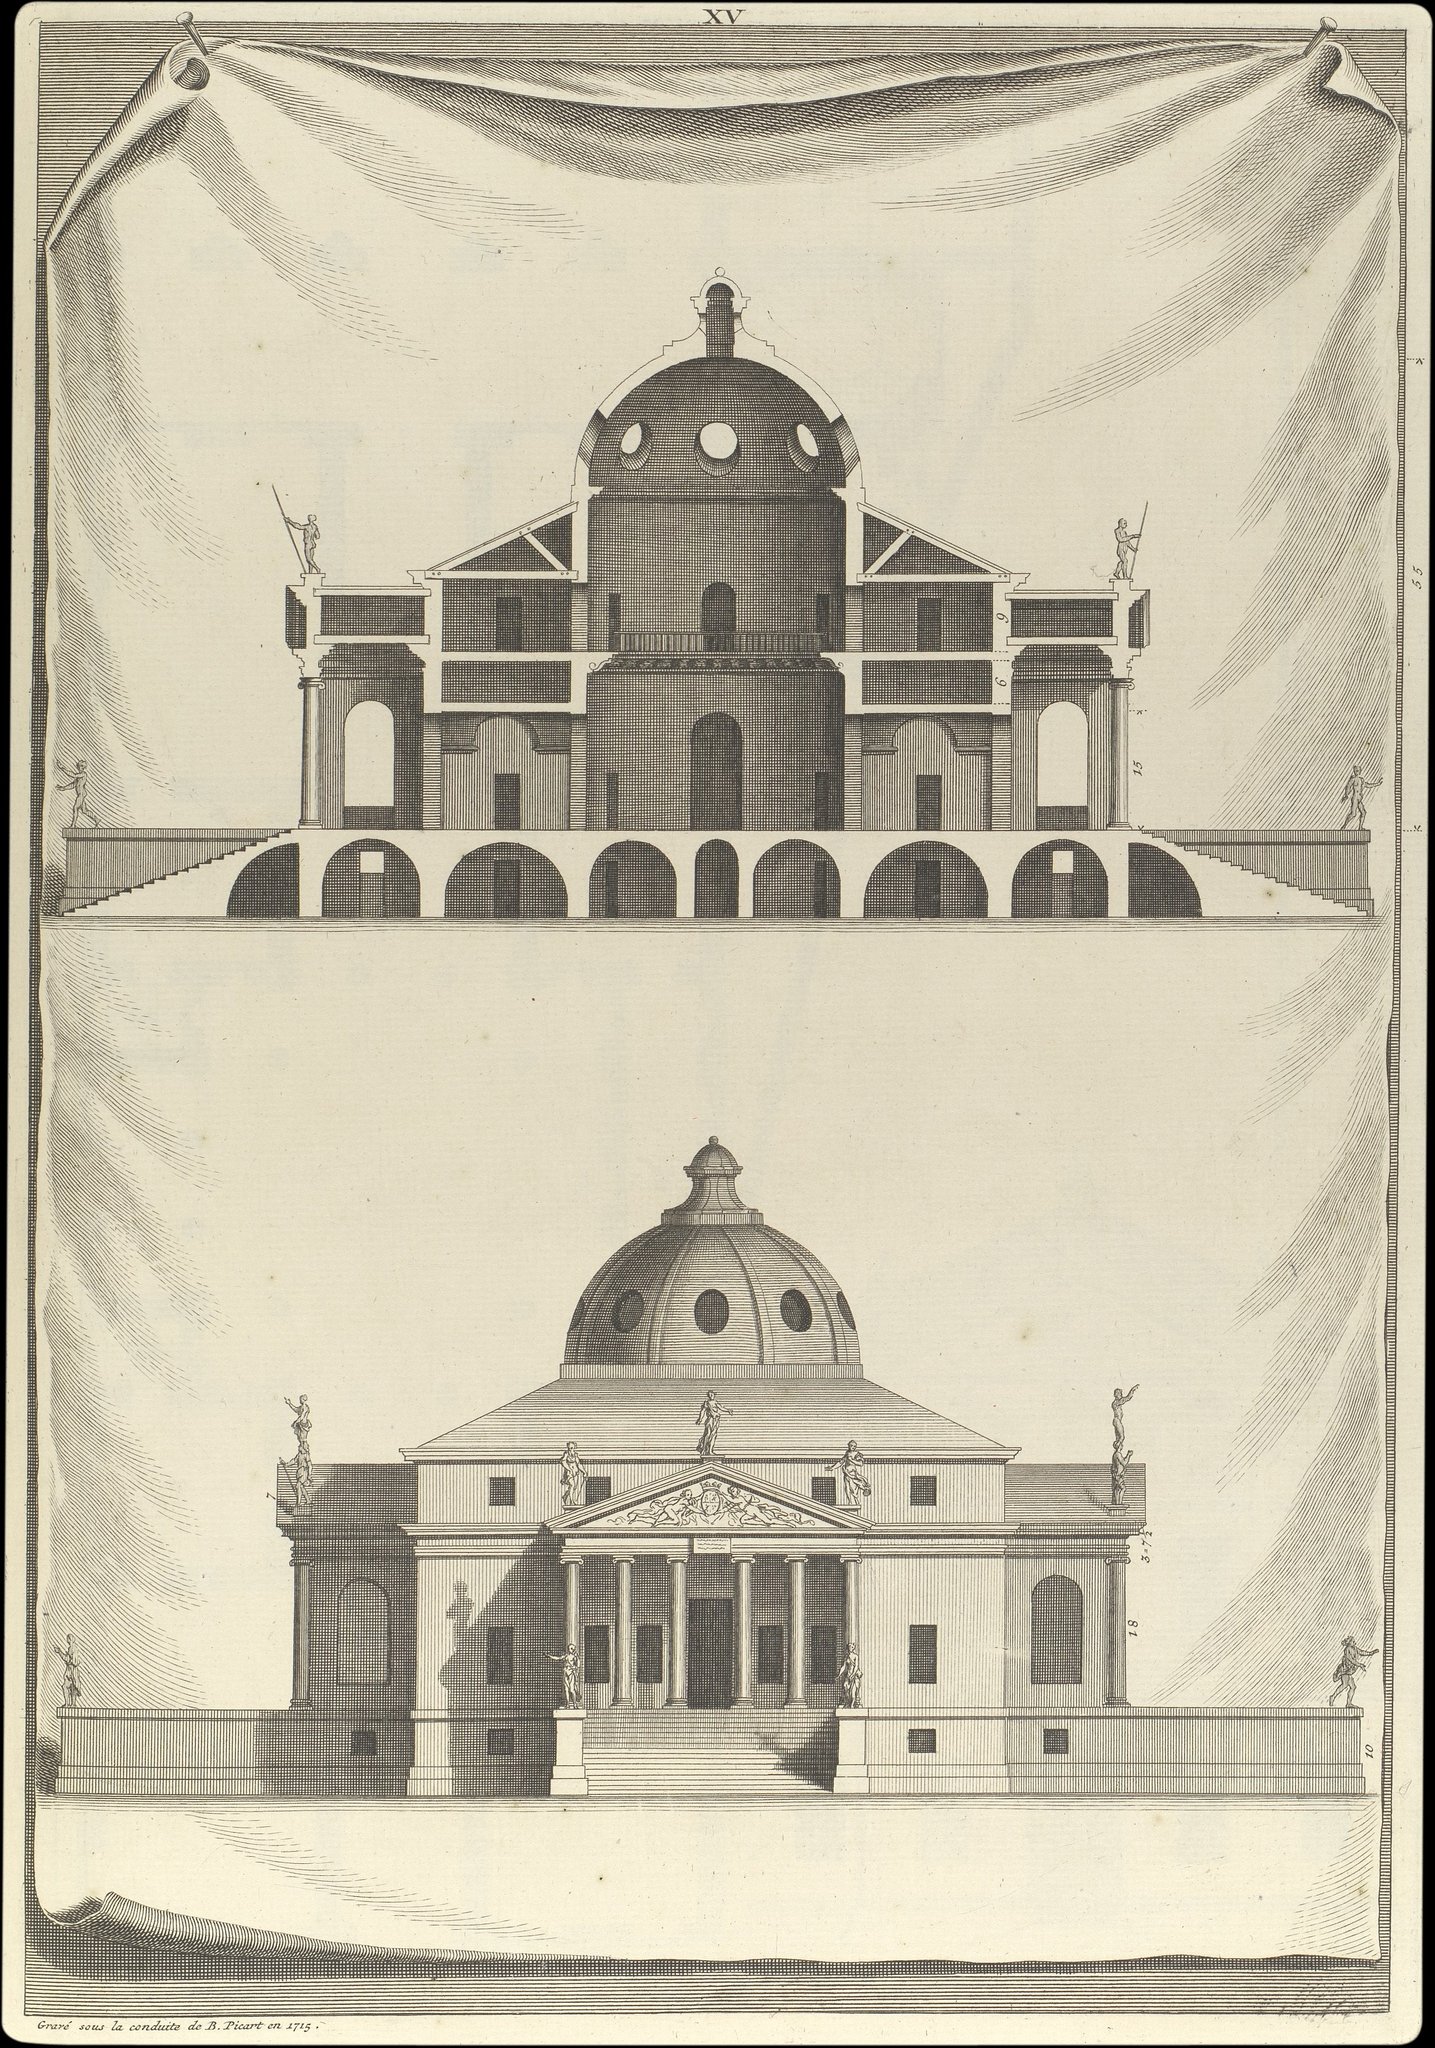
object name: book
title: The Architecture of A. Palladio in Four Books containing a Short Treatise on the Five Orders (L'Architecture de A. Palladio en quatre livres... / Il quattro libri dell'architettura)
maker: andrea palladio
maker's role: author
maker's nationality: italian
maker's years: 1508-1580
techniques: engraving, etching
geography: england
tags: architecture